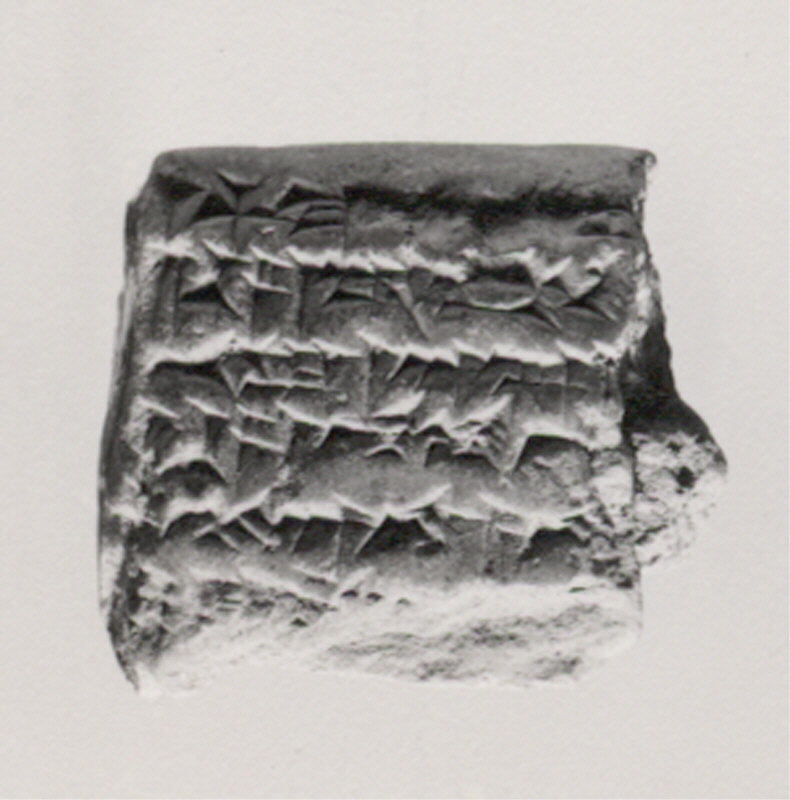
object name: cuneiform tablet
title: Cuneiform tablet: promissory note for silver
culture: babylonian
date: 626-539 BCE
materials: clay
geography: mesopotamia